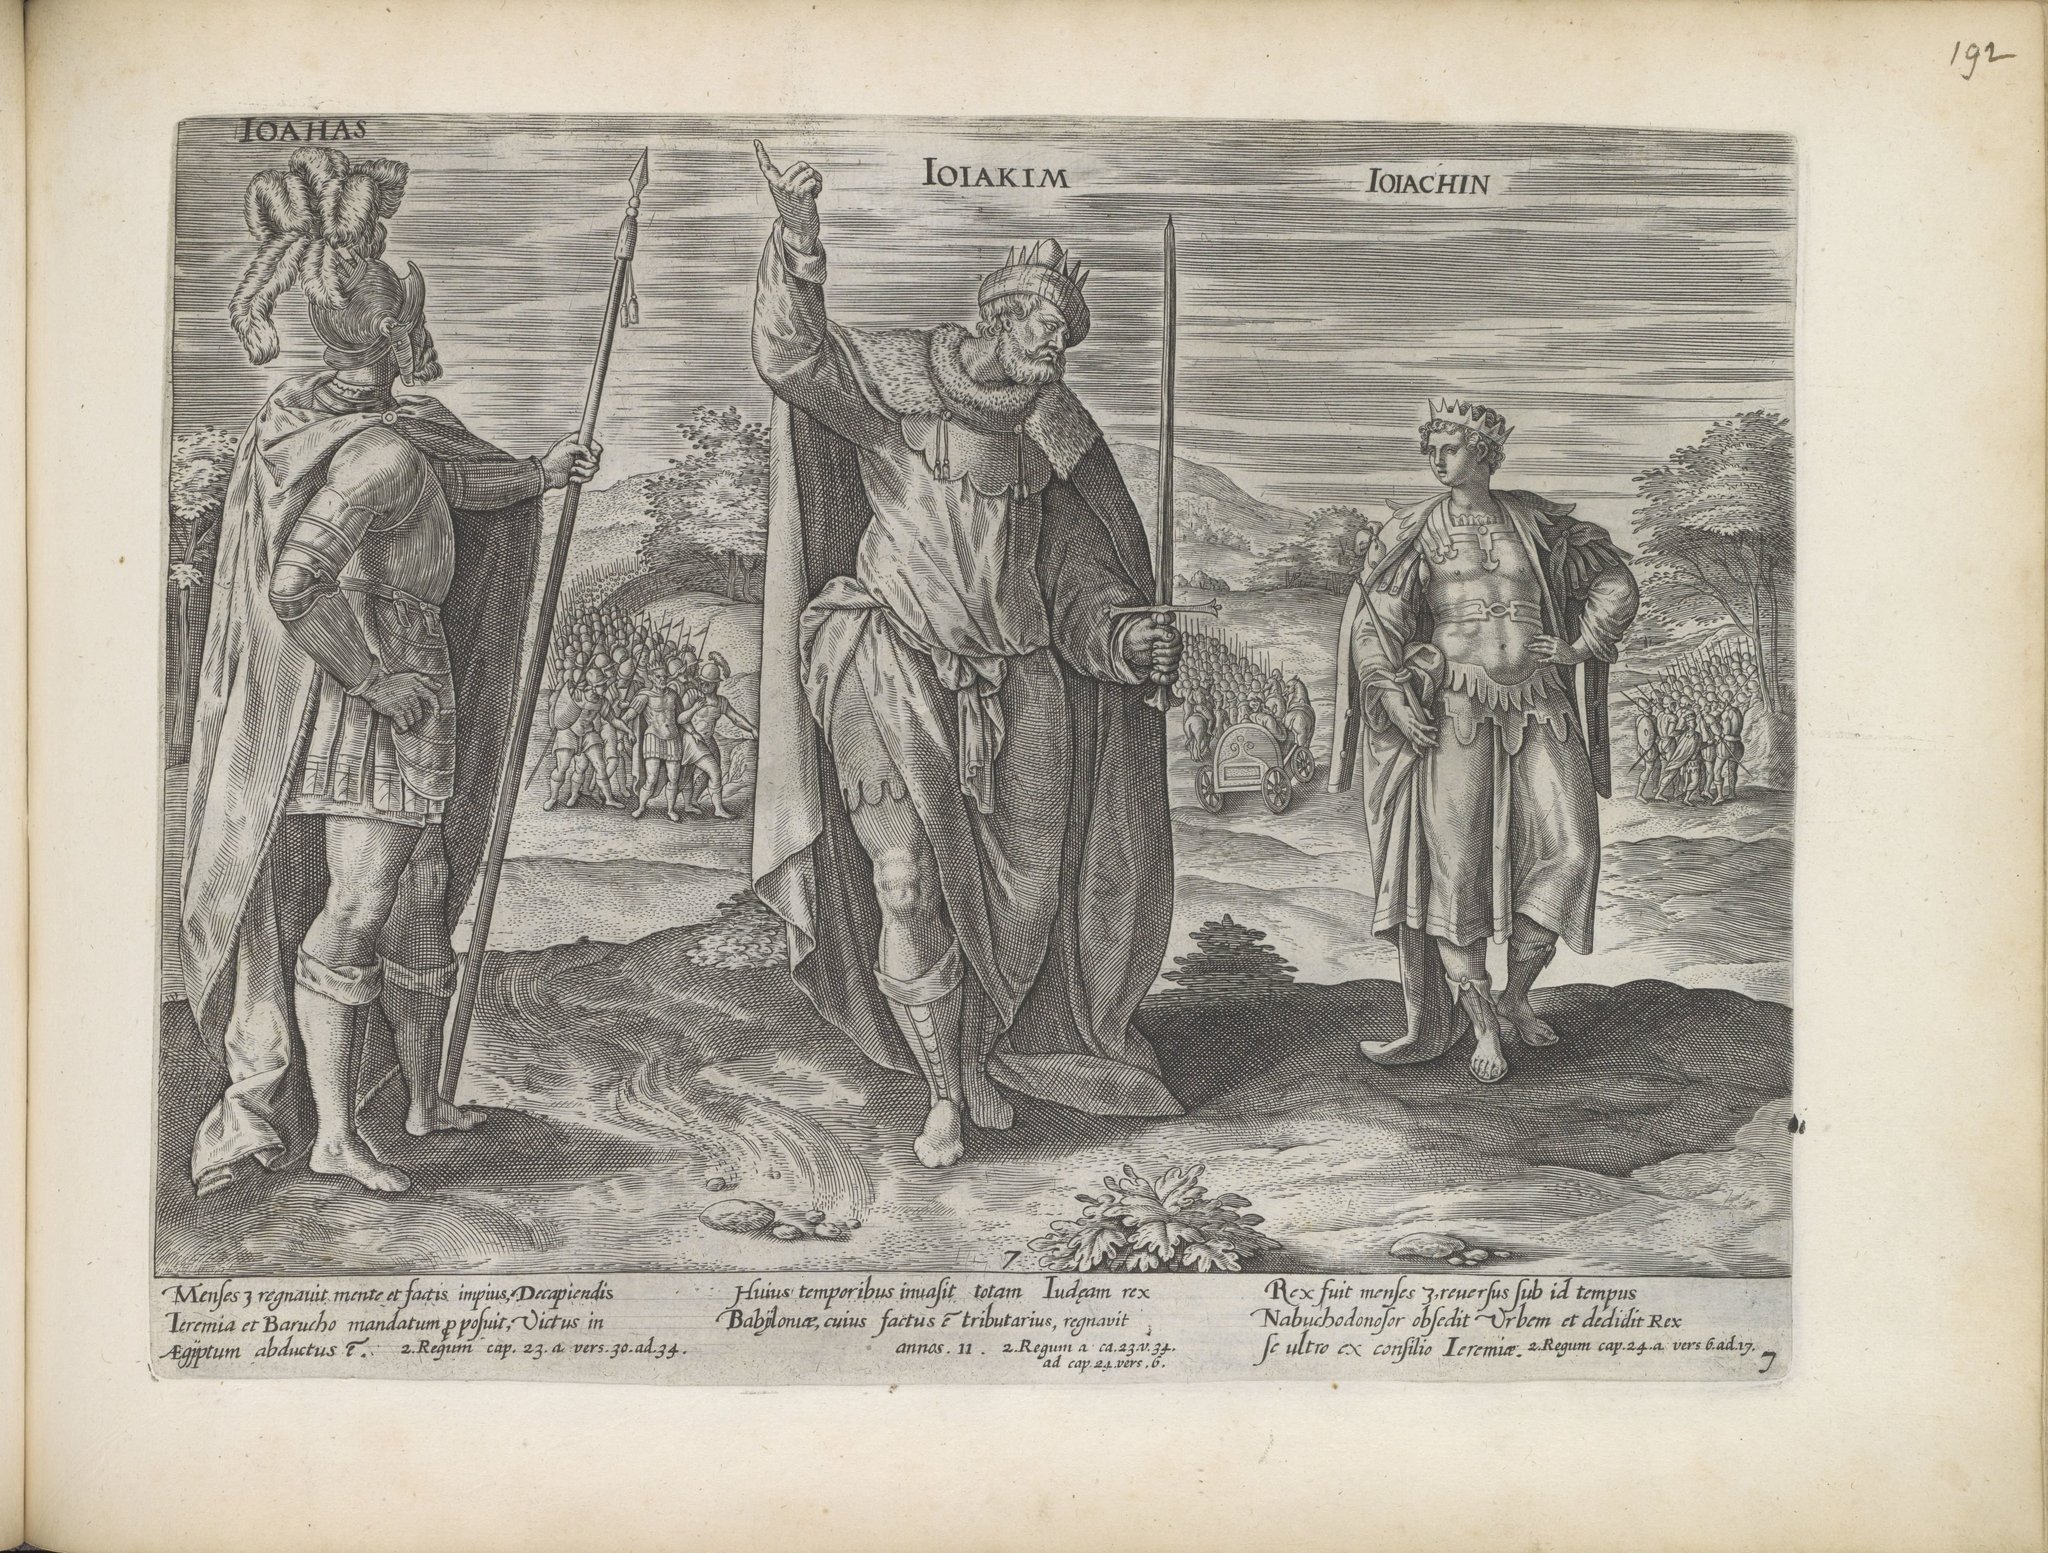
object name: print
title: Joachaz, Jojakim en Jojachin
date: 1585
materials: paper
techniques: engraving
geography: amsterdam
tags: nebuchadnezzar (nabuchodonosor) of babylonia on his way to fight egypt, invades judah and jehoiakim becomes a vassal of babylon (2 kings 24:1; 2 chronicles 36:6-7; daniel 1:1-2), jehohahaz is taken prisoner by king necho ii and brought to egypt, story of jehoiachin (joachin), son of jehoiakim, king of judah (2 kings 24:8-16, 25:27-30; 2 chronicles 36:9-10), story of jehoiakim (joakim), son of josiah, king of judah (2 kings 23:34 - 24:6; 2 chronicles 36:5-8), story of jehohahaz (joahaz), son of josiah, king of judah (2 kings 23:31-34; 2 chronicles 36:1-4), nebuchadnezzar captures the city; jehoiachin, his mother, his wives, and the royal princes are carried away as prisoners (first siege of jerusalem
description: De koningen Joachaz, met speer in de hand, Jojakim, met zwaard in de hand, en de jonge koning Jojachin. Op de achtergrond belangrijke gebeurtenissen uit hun leven. Links op de achtergrond de gevangenneming van Joachaz door het leger van farao Necho. Midden op de achtergrond wordt Jojakim meegenomen doot het leger van koning Nebukadnessar. Rechts op de achtergrond de gevangenneming van Jojachin door het leger van koning Nebukadnessar. Onder de voorstelling verwijzingen naar de Bijbelteksten in 2 Kon. 23-24 in het Latijn. Deze prent maakt deel uit van een album.